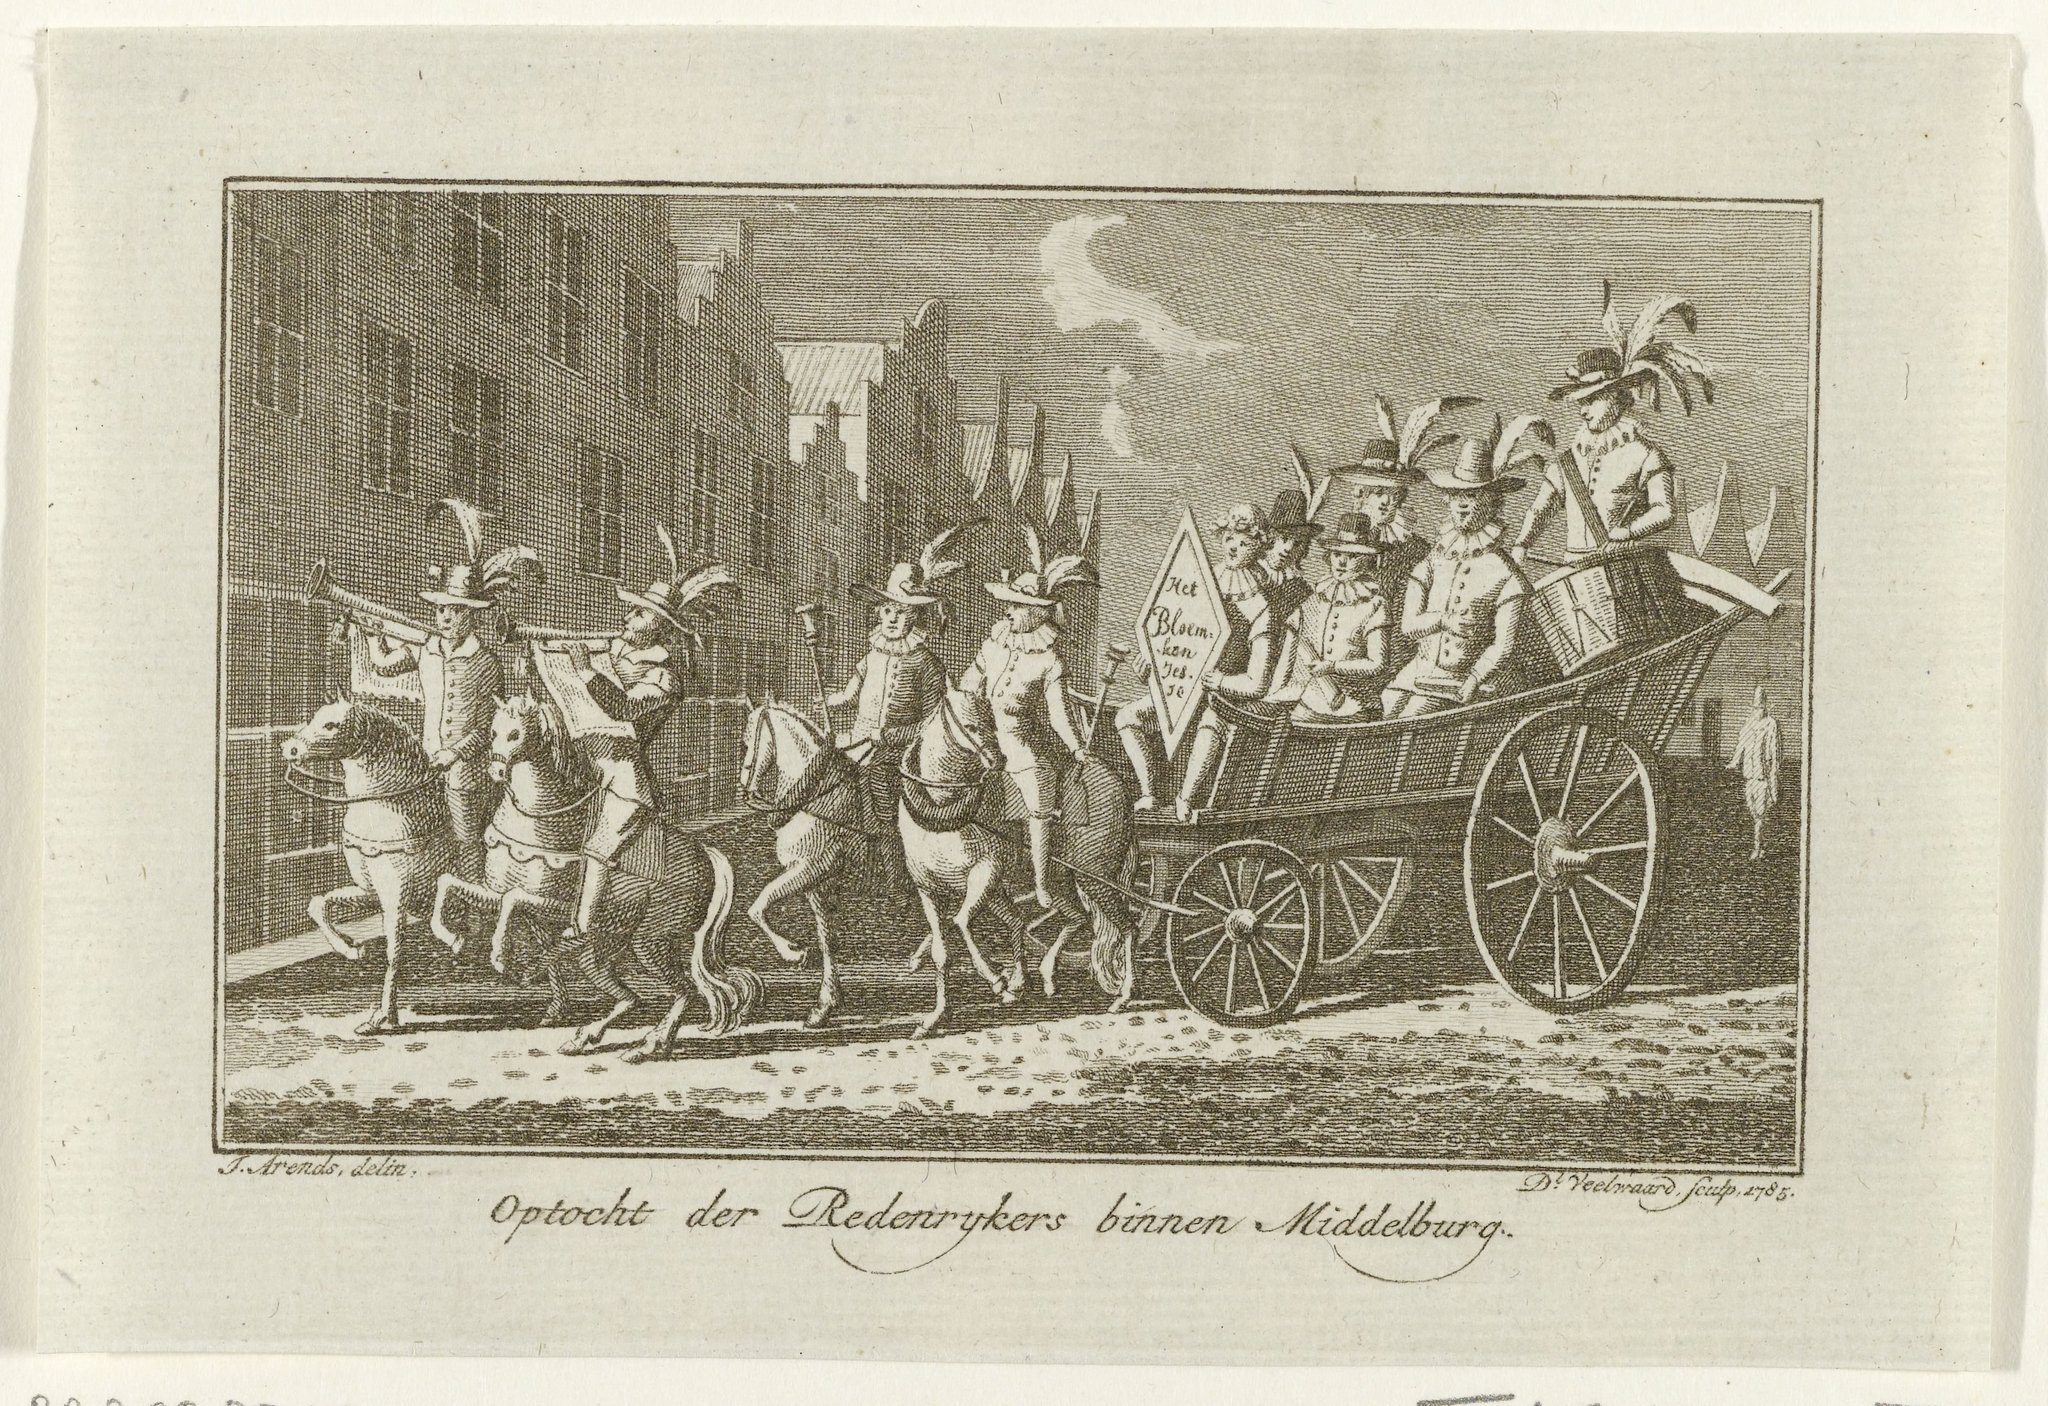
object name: print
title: Optocht van Rederijkers te Middelburg, ca. 1785-1786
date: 1785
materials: paper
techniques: etching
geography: middelburg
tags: chamber of rhetoric (dutch: 'rederijkerskamer'), middelburg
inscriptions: collector's mark: Lugt 2228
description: Optocht van een groep rederijkers van de rederijkerskamer Het Bloemken Jesse te Middelburg, ca. 1785-1786.